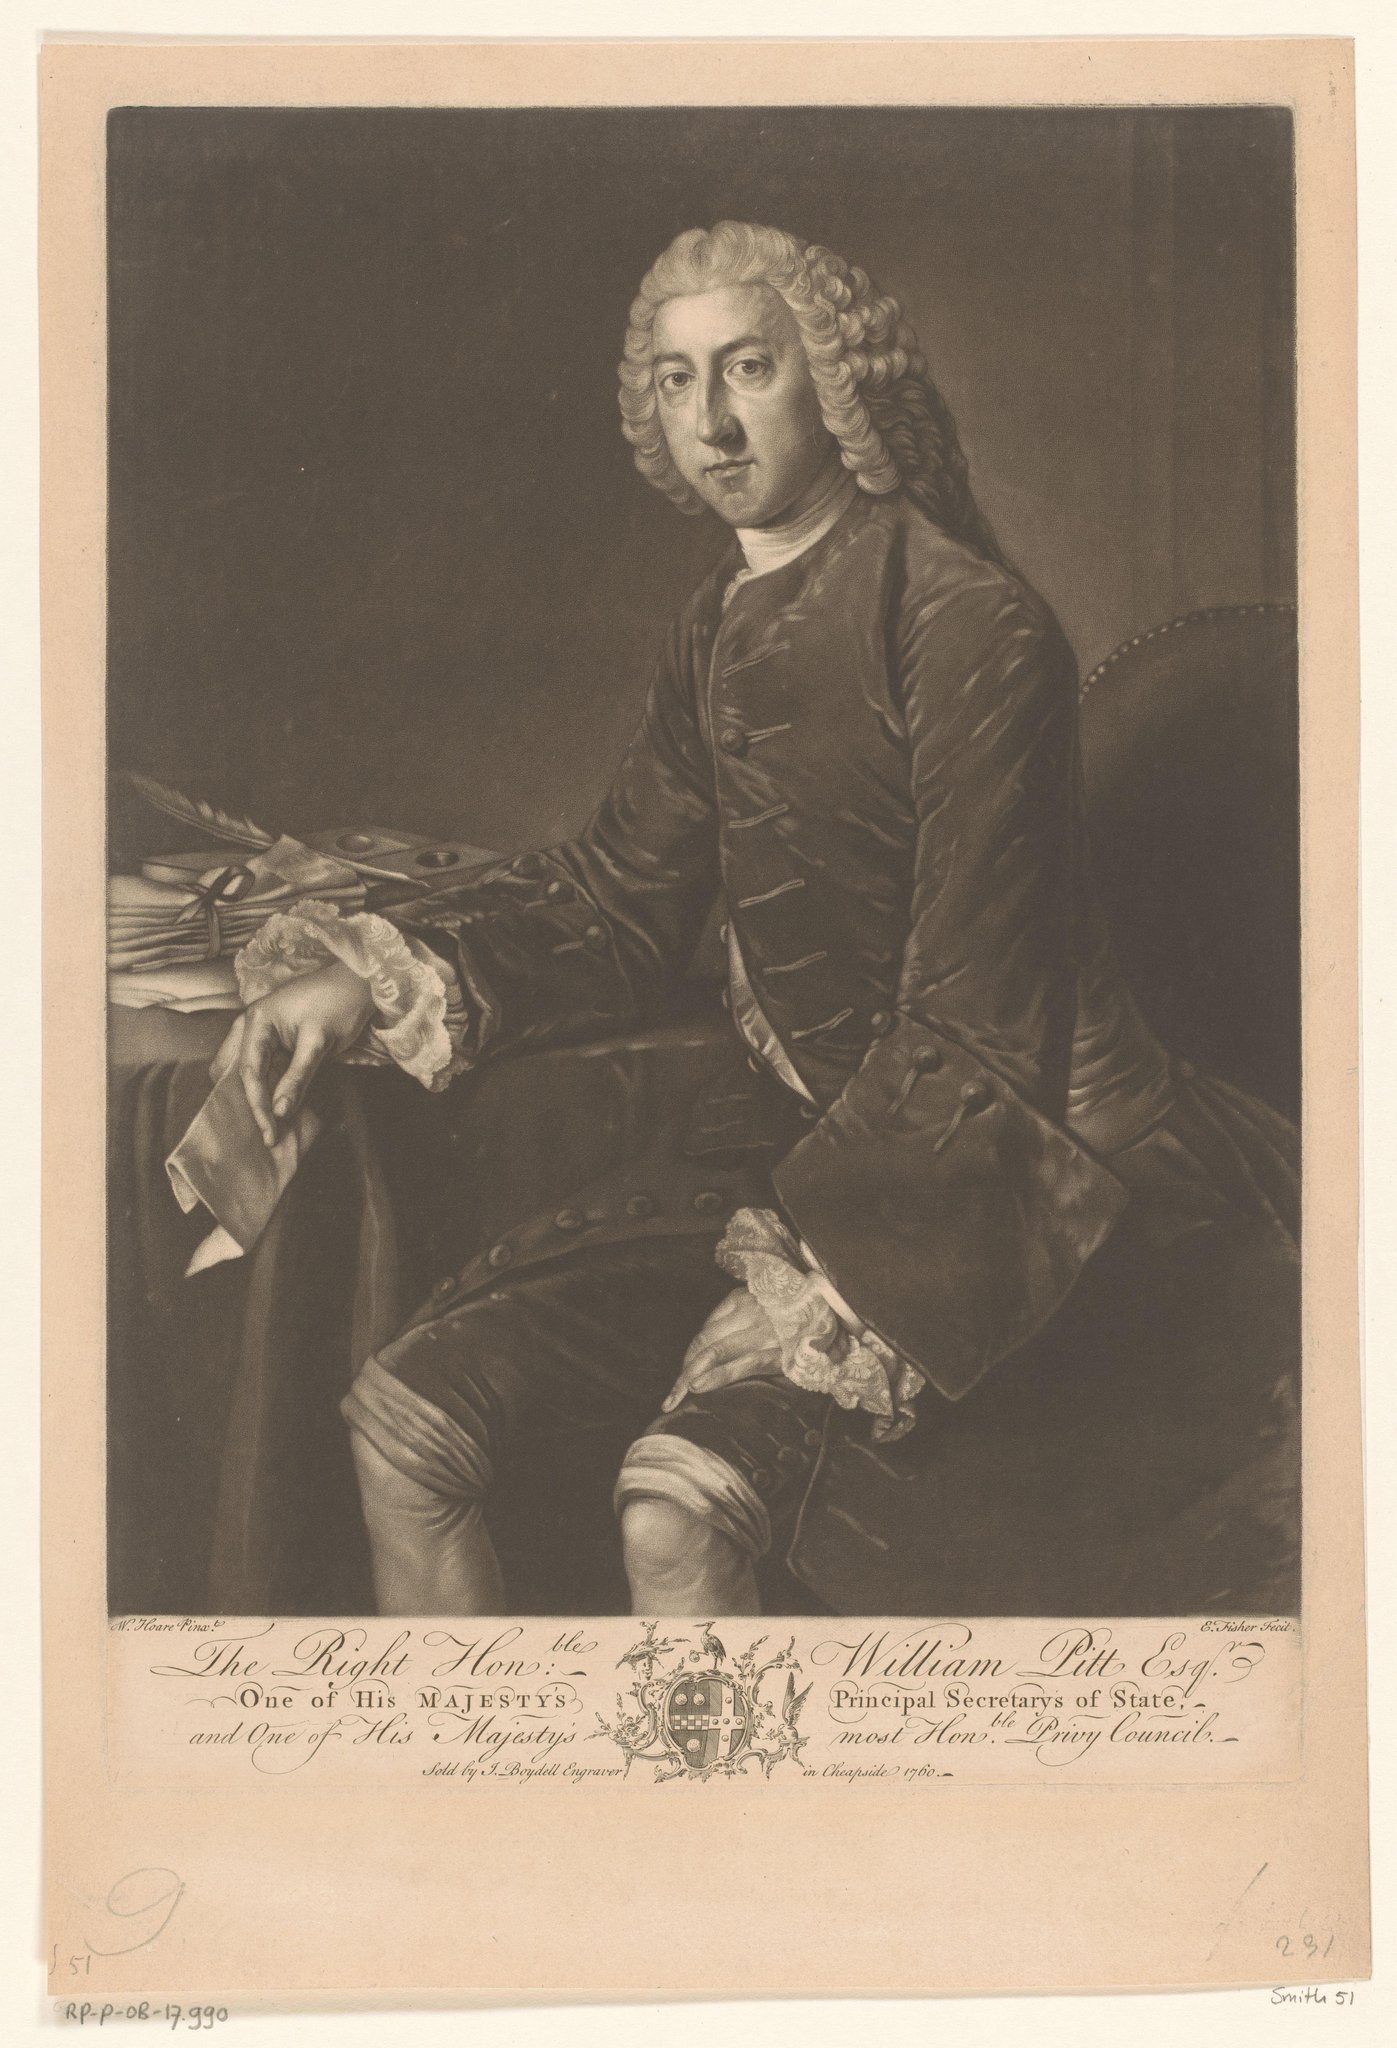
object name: print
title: Portret van William Pitt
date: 1760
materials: paper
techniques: mezzotint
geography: london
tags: london, earl, politician, william pitt (i), historical persons, politician, e.g. party leader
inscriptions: collector's mark: Lugt 2228